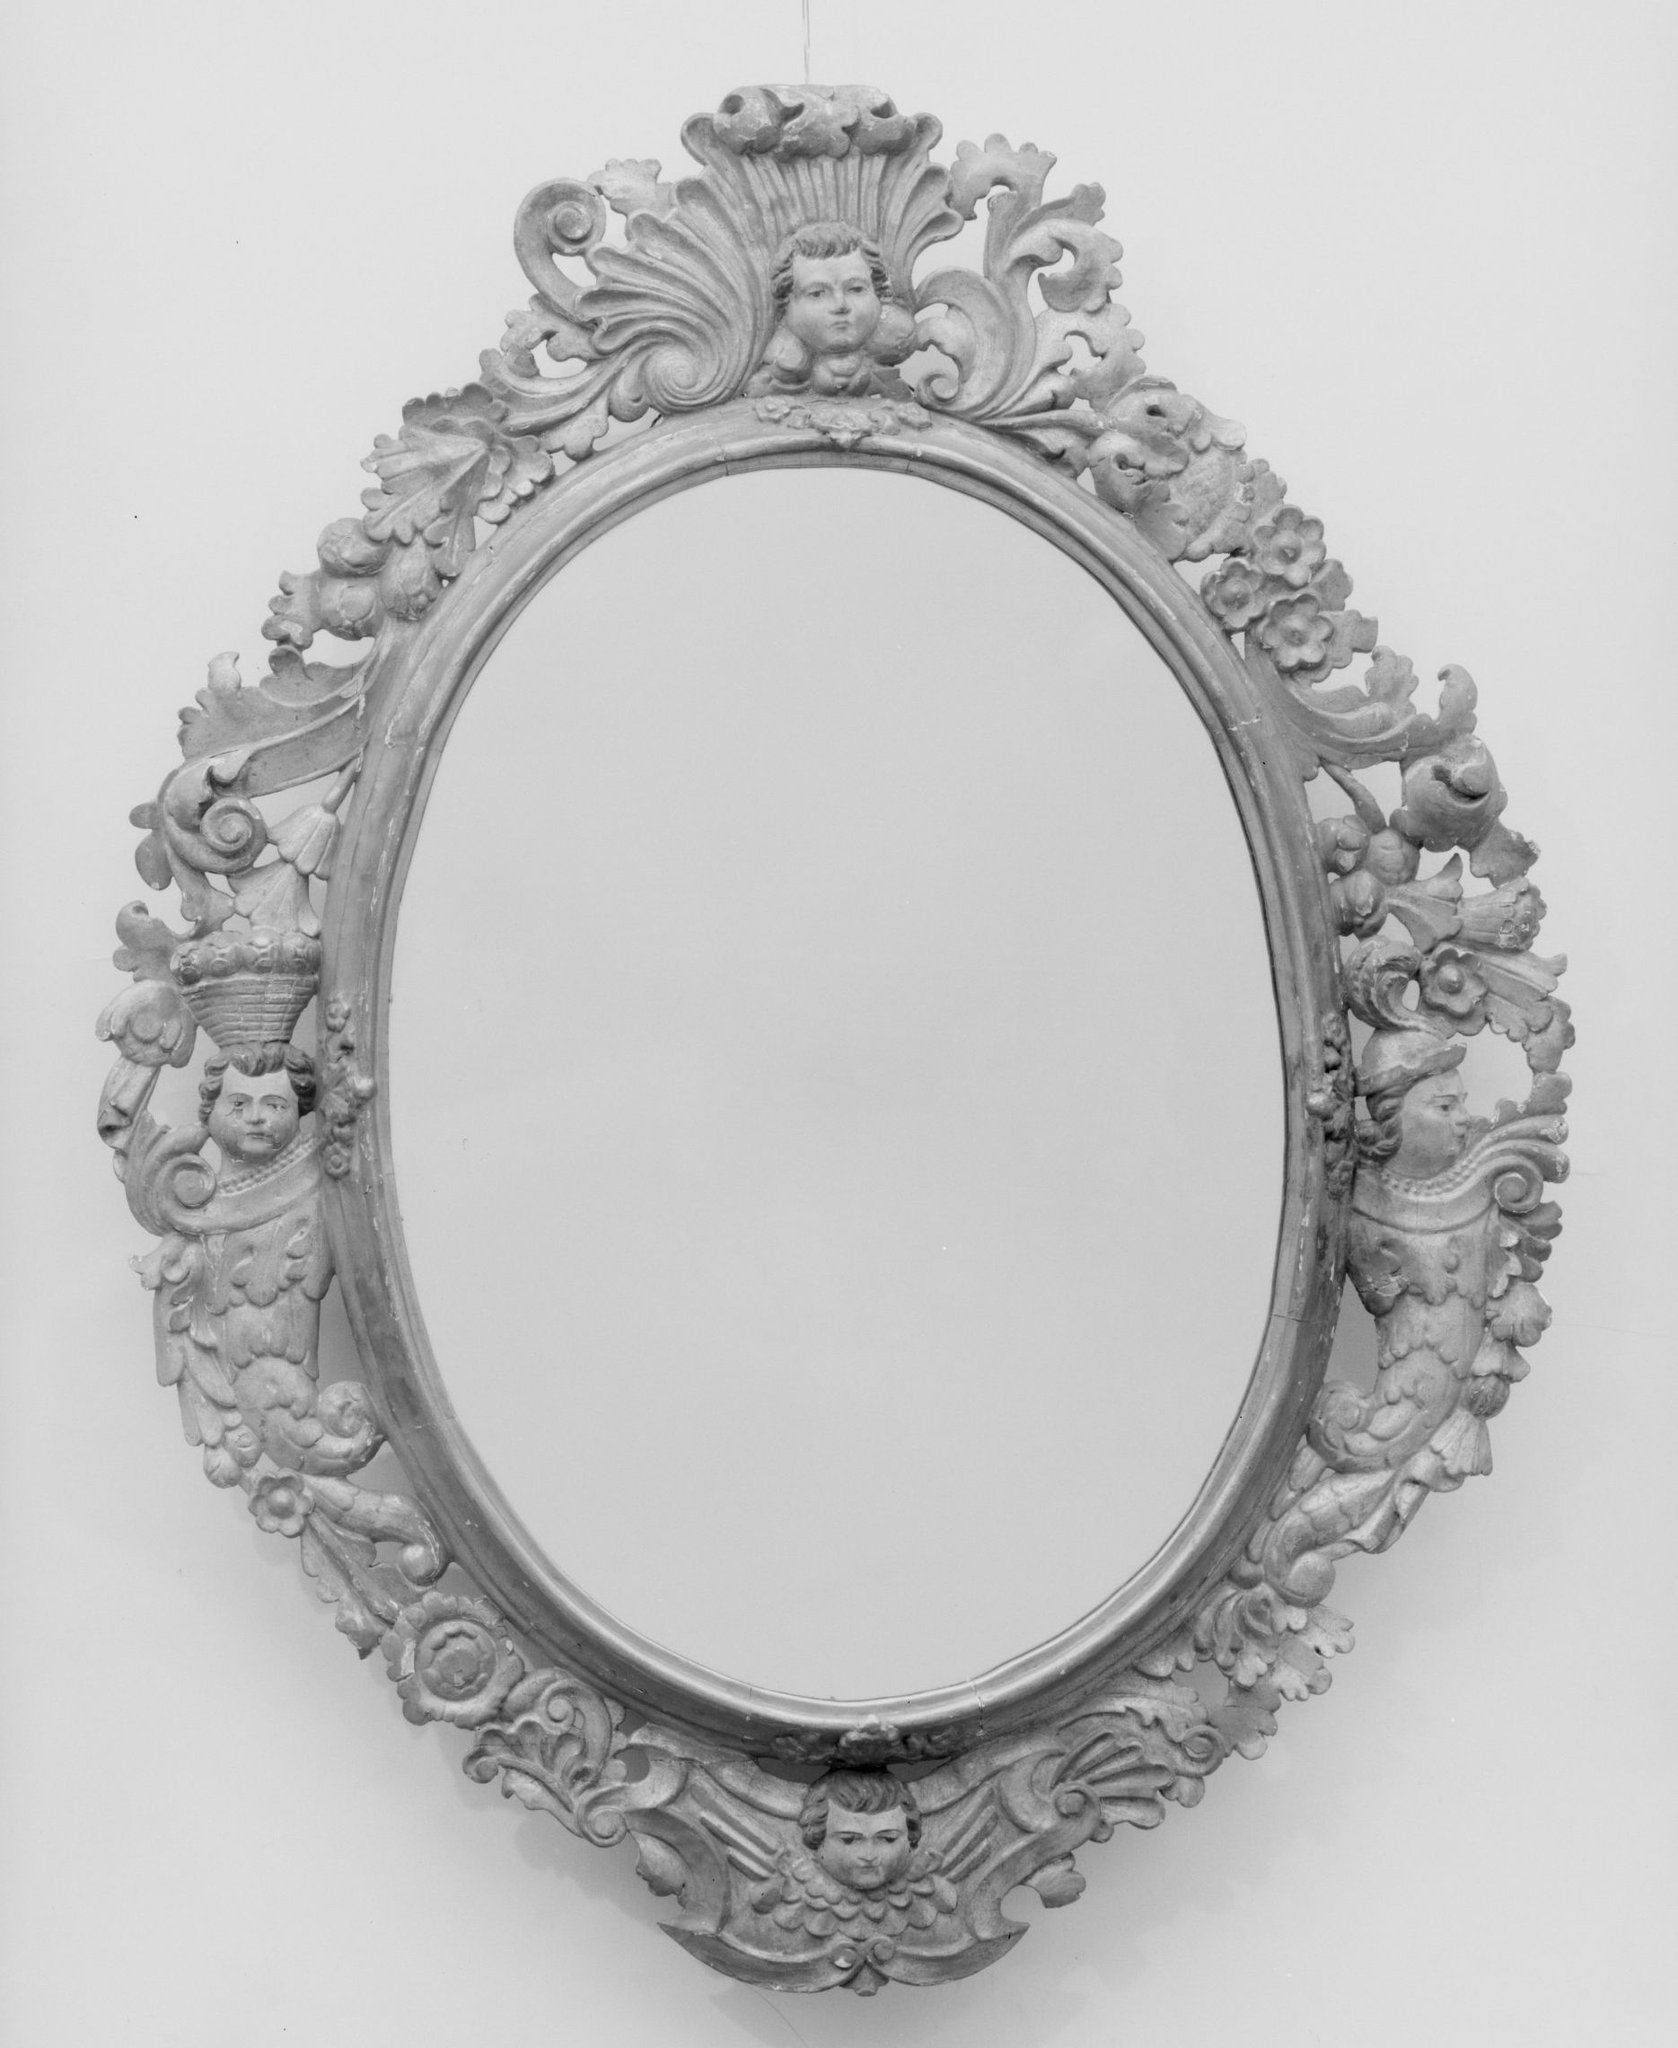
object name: looking glass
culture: mexican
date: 1700-1800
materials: glass, wood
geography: mexico